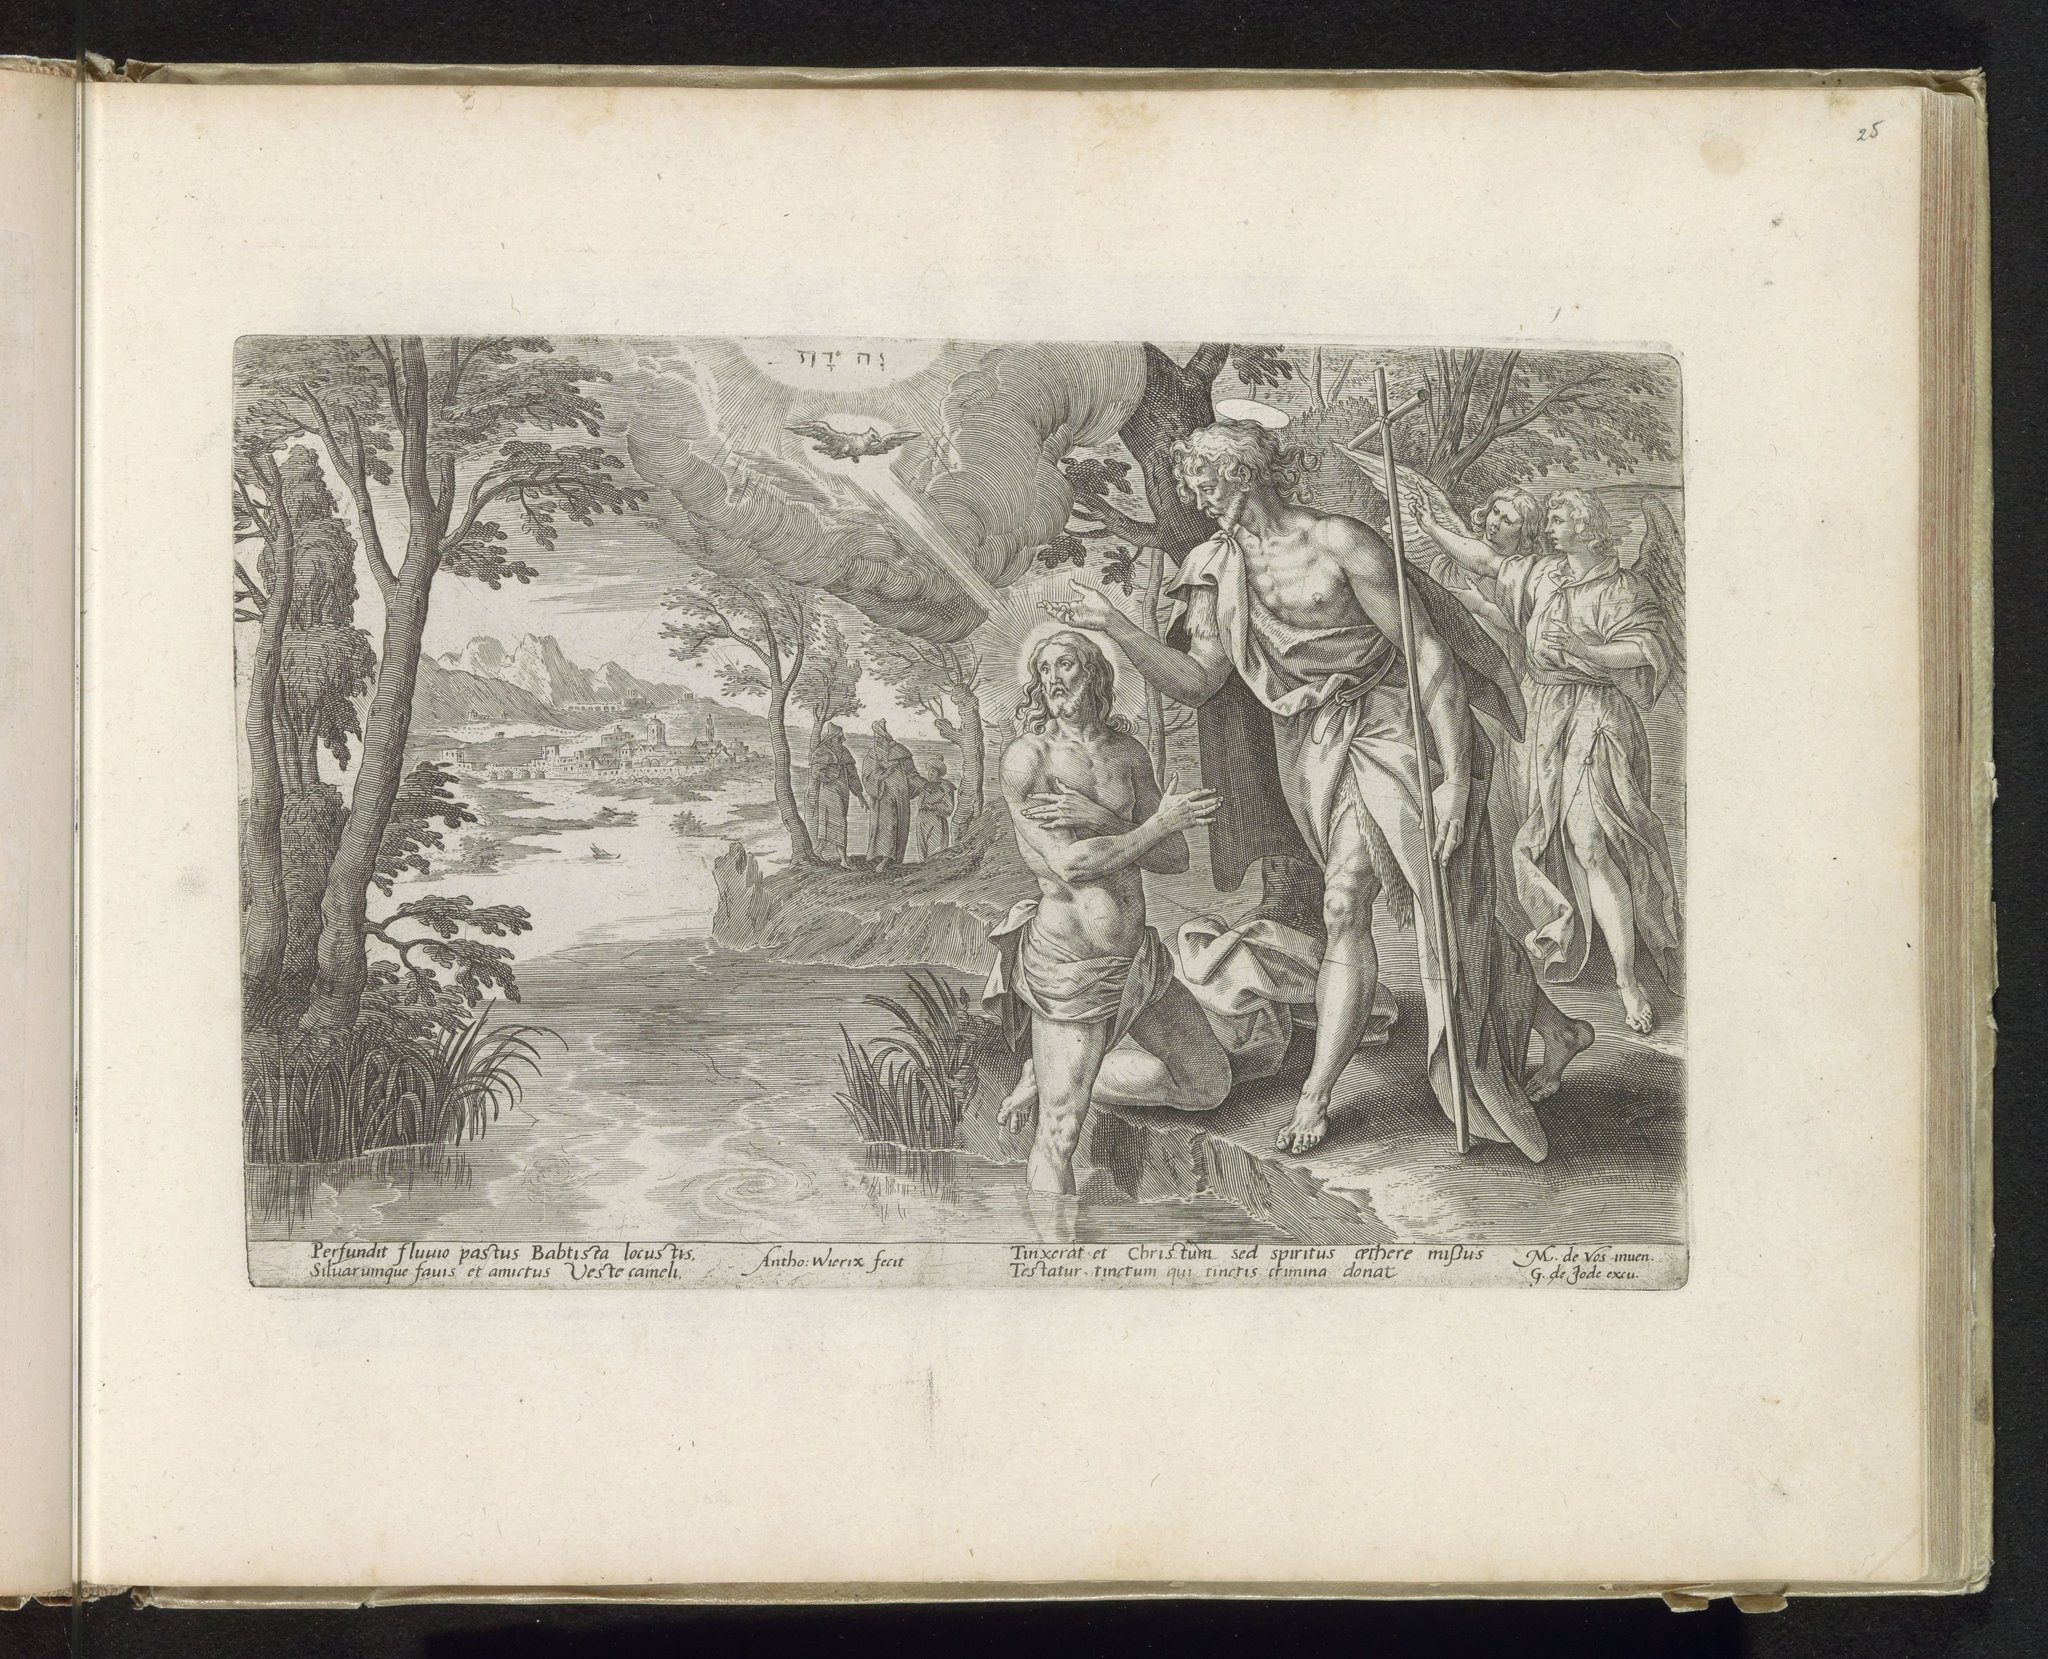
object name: print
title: Thesaurus novi Testamenti elegantissimis iconibus expressus continens historias atque miracula doni nostri Iesu Christi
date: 1585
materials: paper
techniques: engraving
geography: antwerp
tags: baptism of christ in the river jordan: john the baptist pouring out water on christ's head: the holy ghost descends, tetragram (in roman or hebrew script) ~ symbol of god the father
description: Christus wordt gedoopt door Johannes de Doper en de Heilige Geest daalt als een duif op hem neer. Twee engelen kijken rechts toe. Onder de voorstelling een verwijzing in het Latijn naar de Bijbeltekst. Deze prent maakt deel uit van een album.